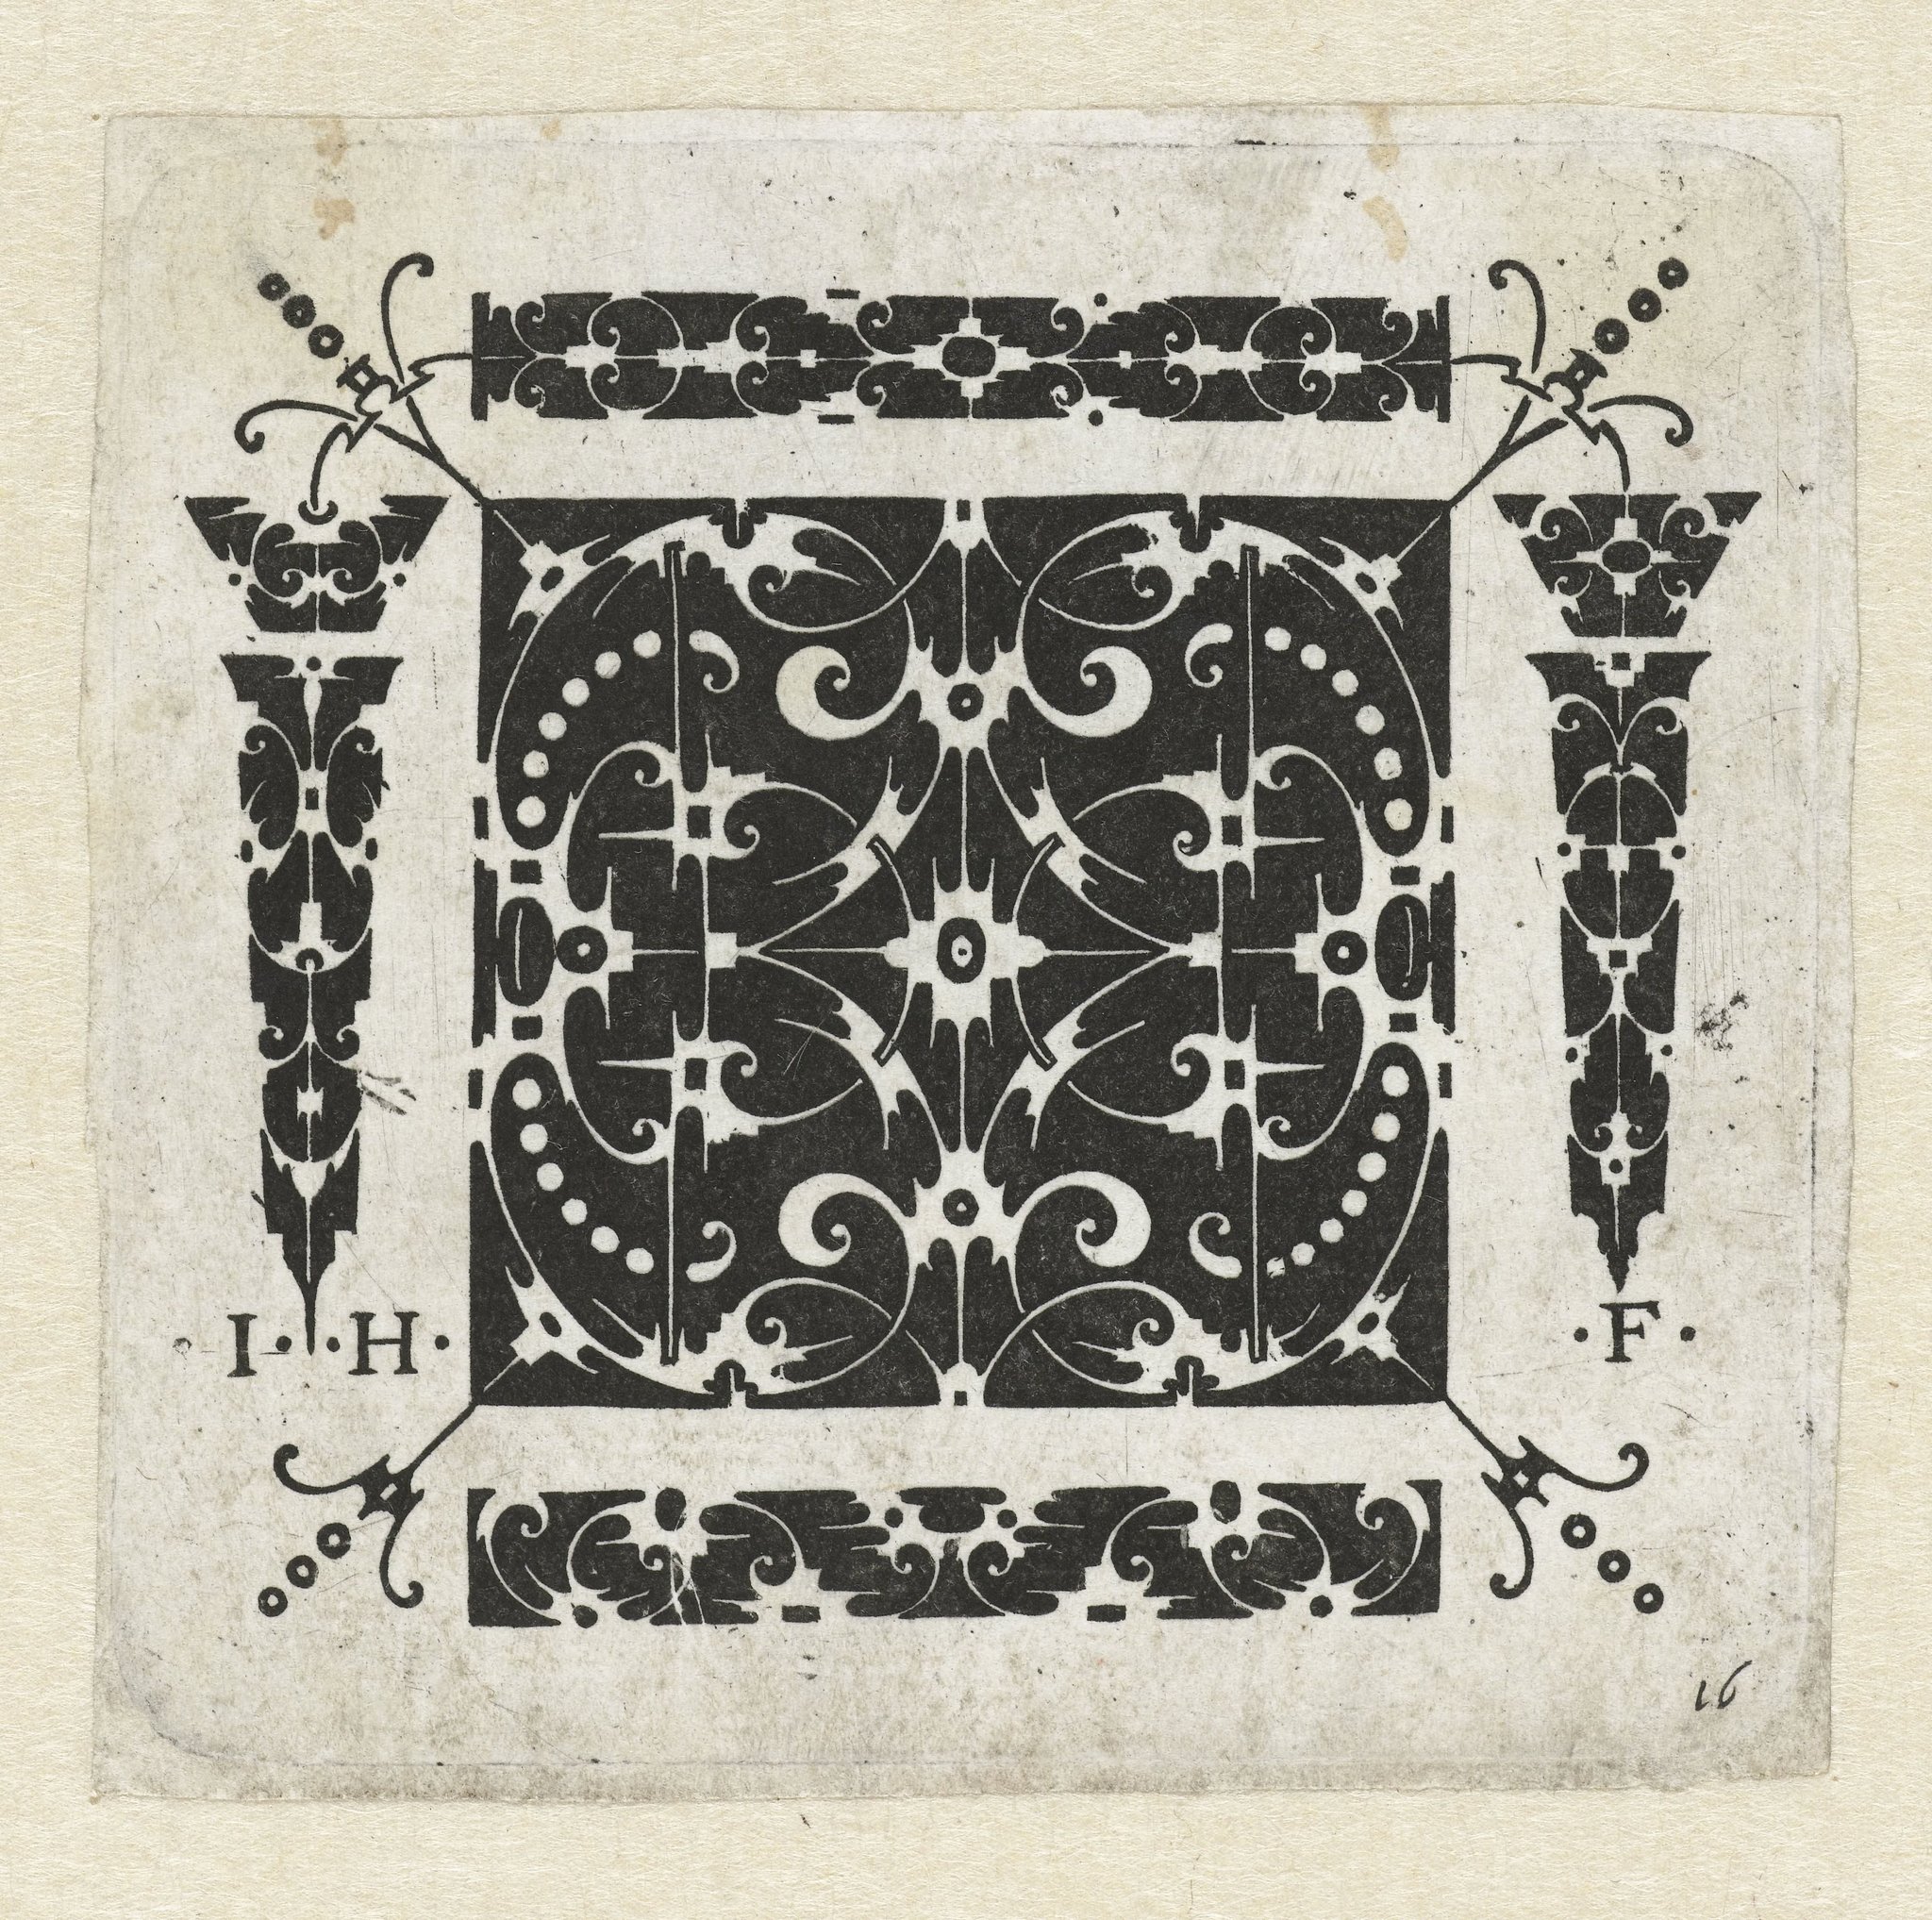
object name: ornament print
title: Zwartornamenten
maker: jacques hurtu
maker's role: goldsmith, print maker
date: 1619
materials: paper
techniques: engraving, etching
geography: paris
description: Het vierkant en de zes kleinere motieven zijn gedecoreerd met witte ranken en Schweifwerk op een zwarte ondergrond.